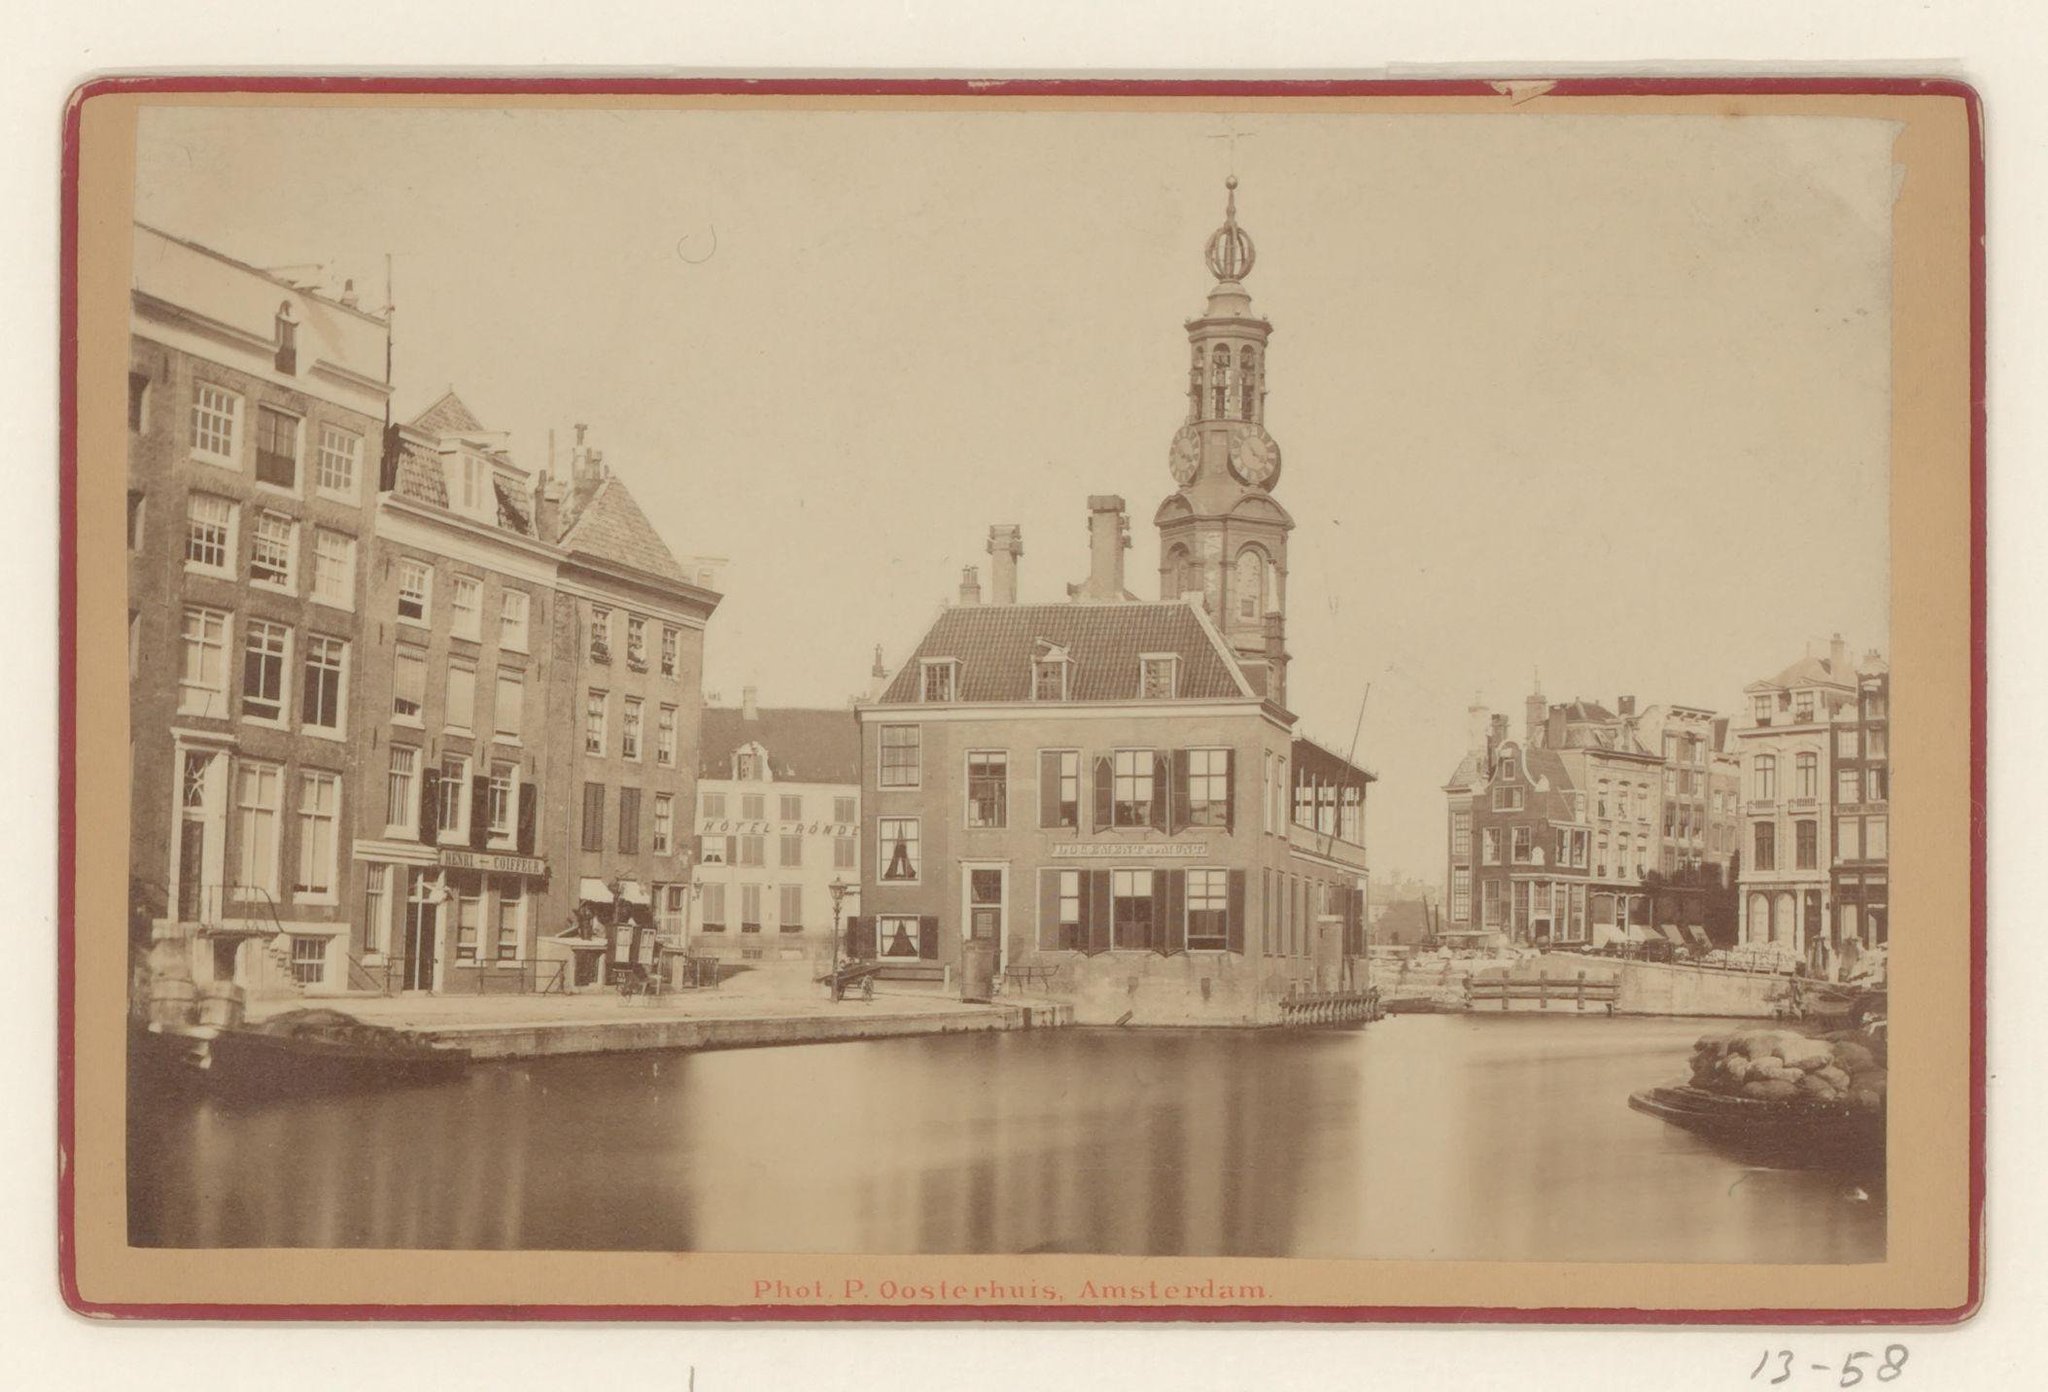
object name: cabinet photograph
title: Gezicht op het Singel met Logement De Munt en de Munttoren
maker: pieter oosterhuis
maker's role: draughtsman, print maker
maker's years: 1816-1885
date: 1831-1885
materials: cardboard, paper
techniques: albumen print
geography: amsterdam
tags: tower, clock tower ~ monumental adornment, city-view in general; 'veduta', canal, the usual house or row of houses, bridge in city across river, canal, etc., hotel, hostelry, inn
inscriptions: collector's mark: ‘13,58’ Lugt 1641b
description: Onderwerpsrubriek binnen de Atlas Amsterdam: Oude Schans, Schoutensteeg, Singel (Korte), Singel.